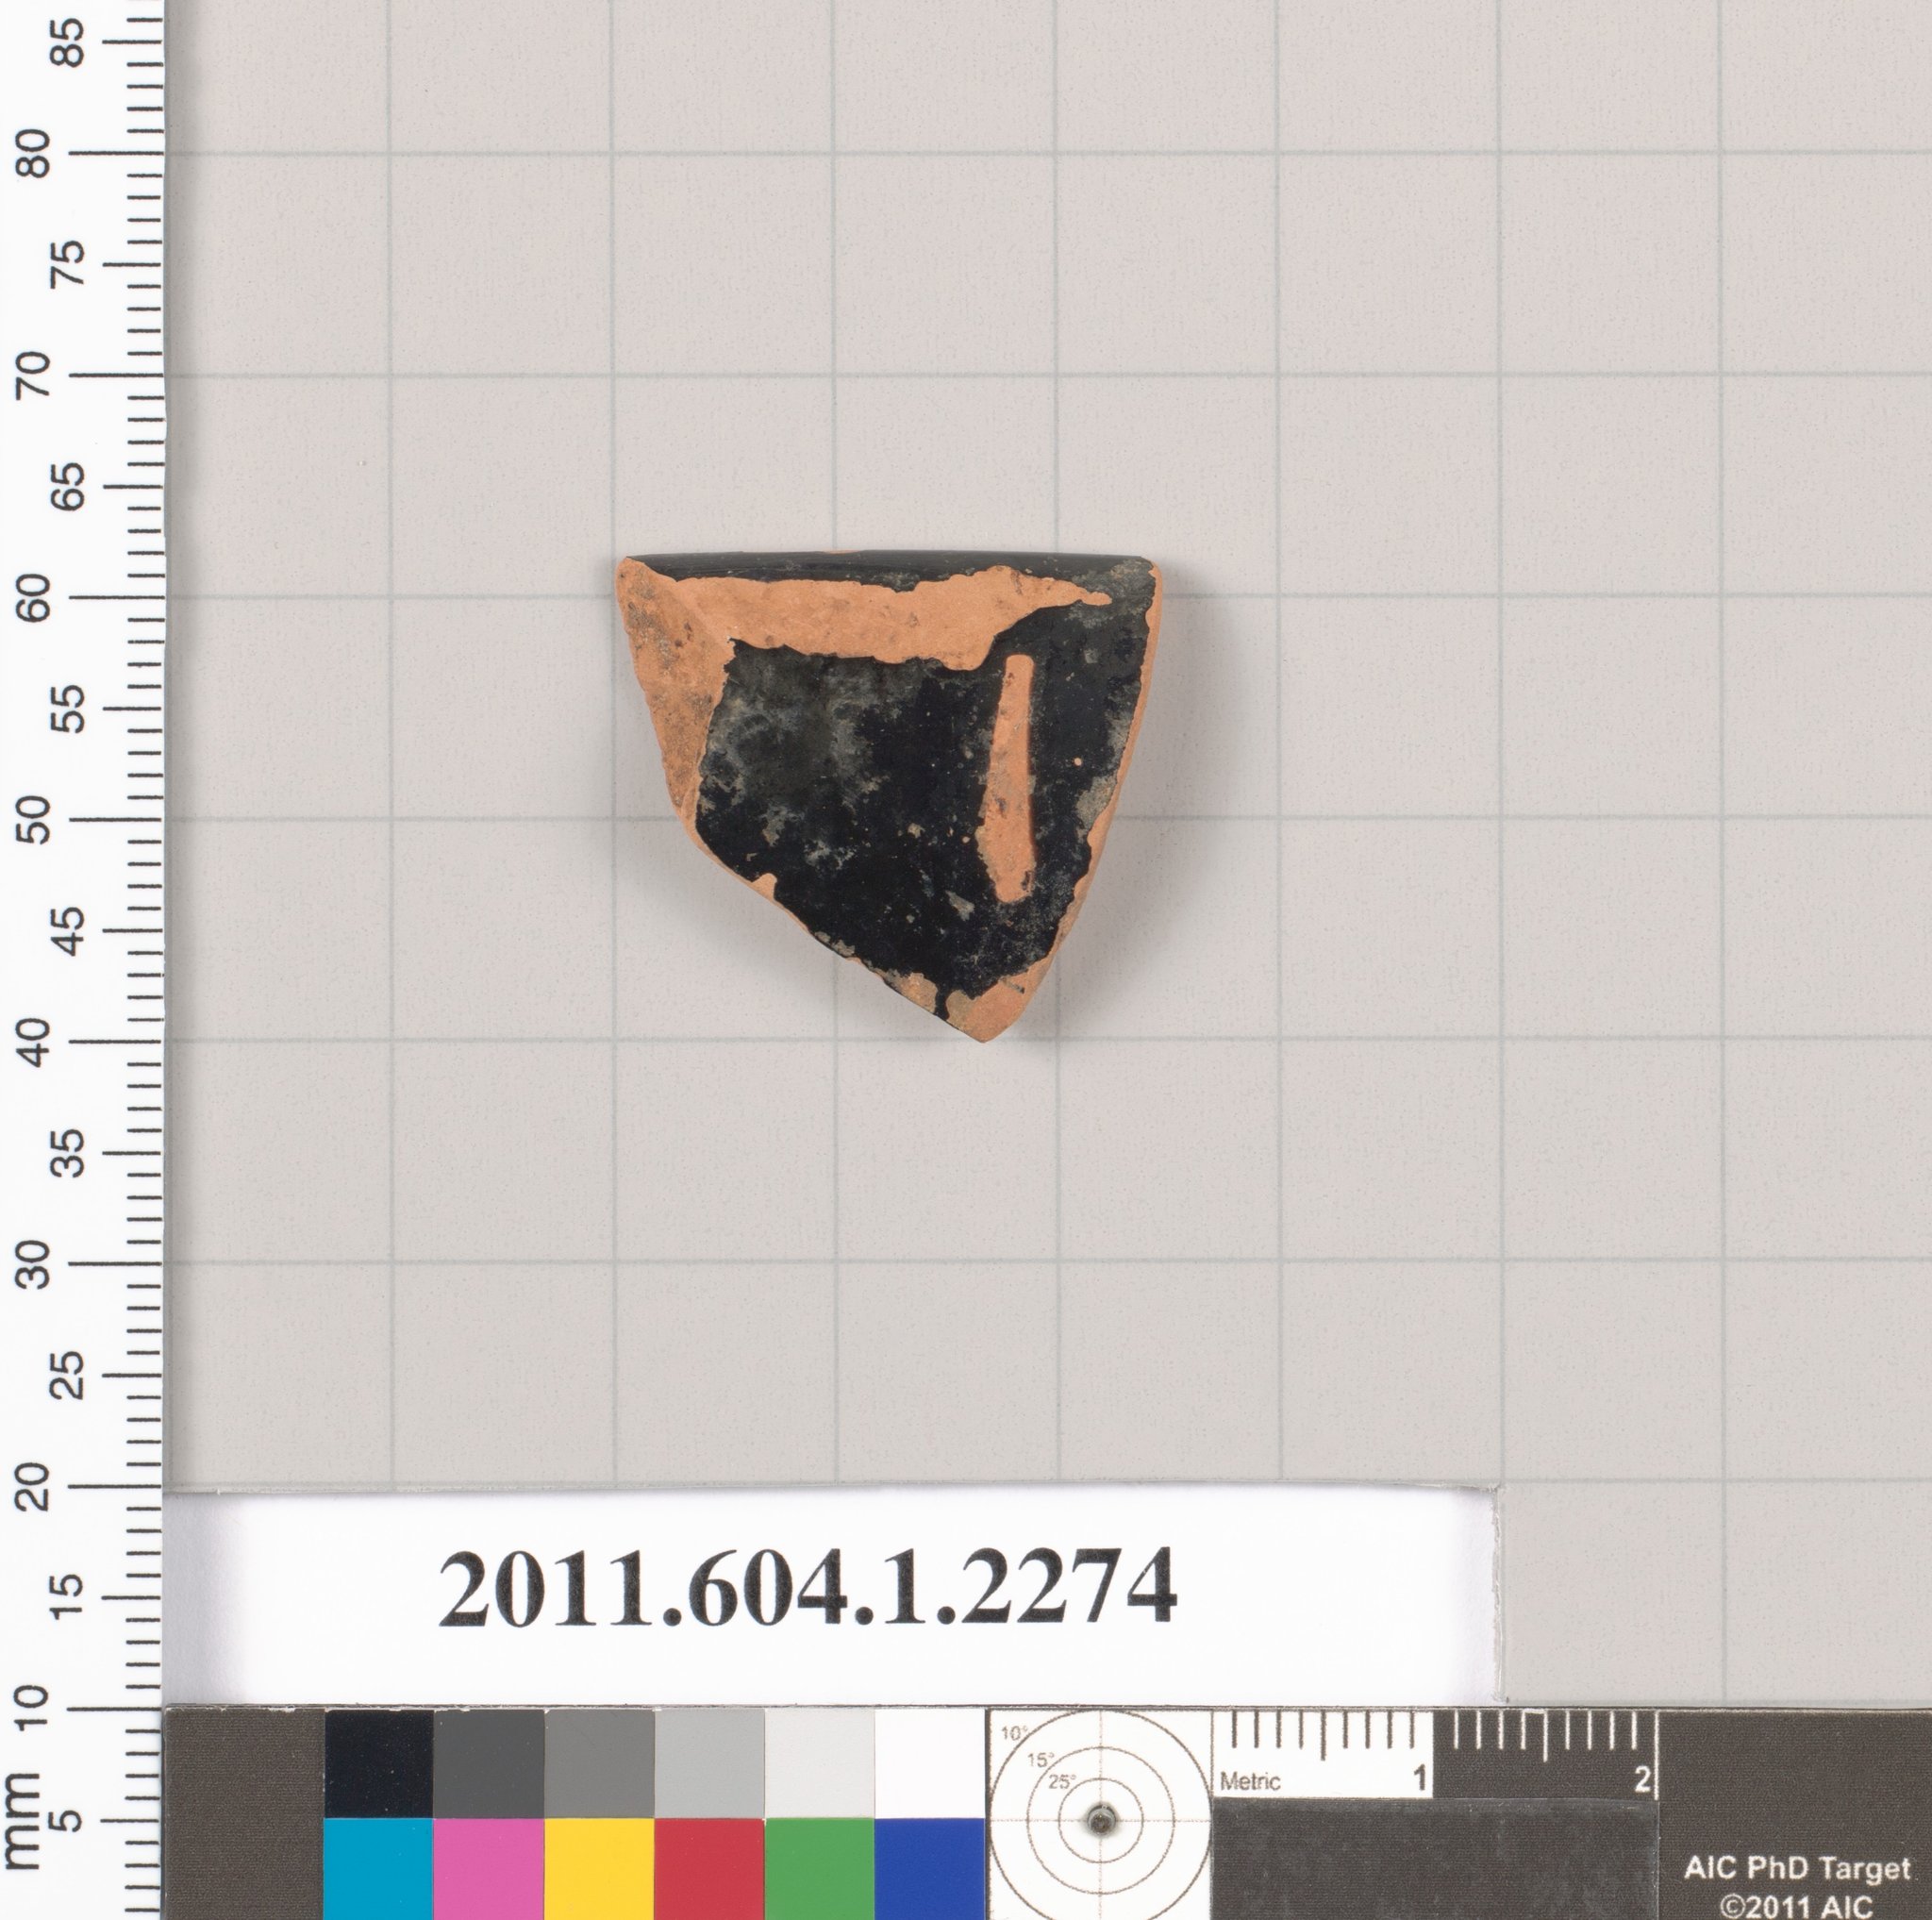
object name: kylix fragment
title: Terracotta rim fragment of a kylix (drinking cup)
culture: greek, attic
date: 467-435 BCE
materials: terracotta